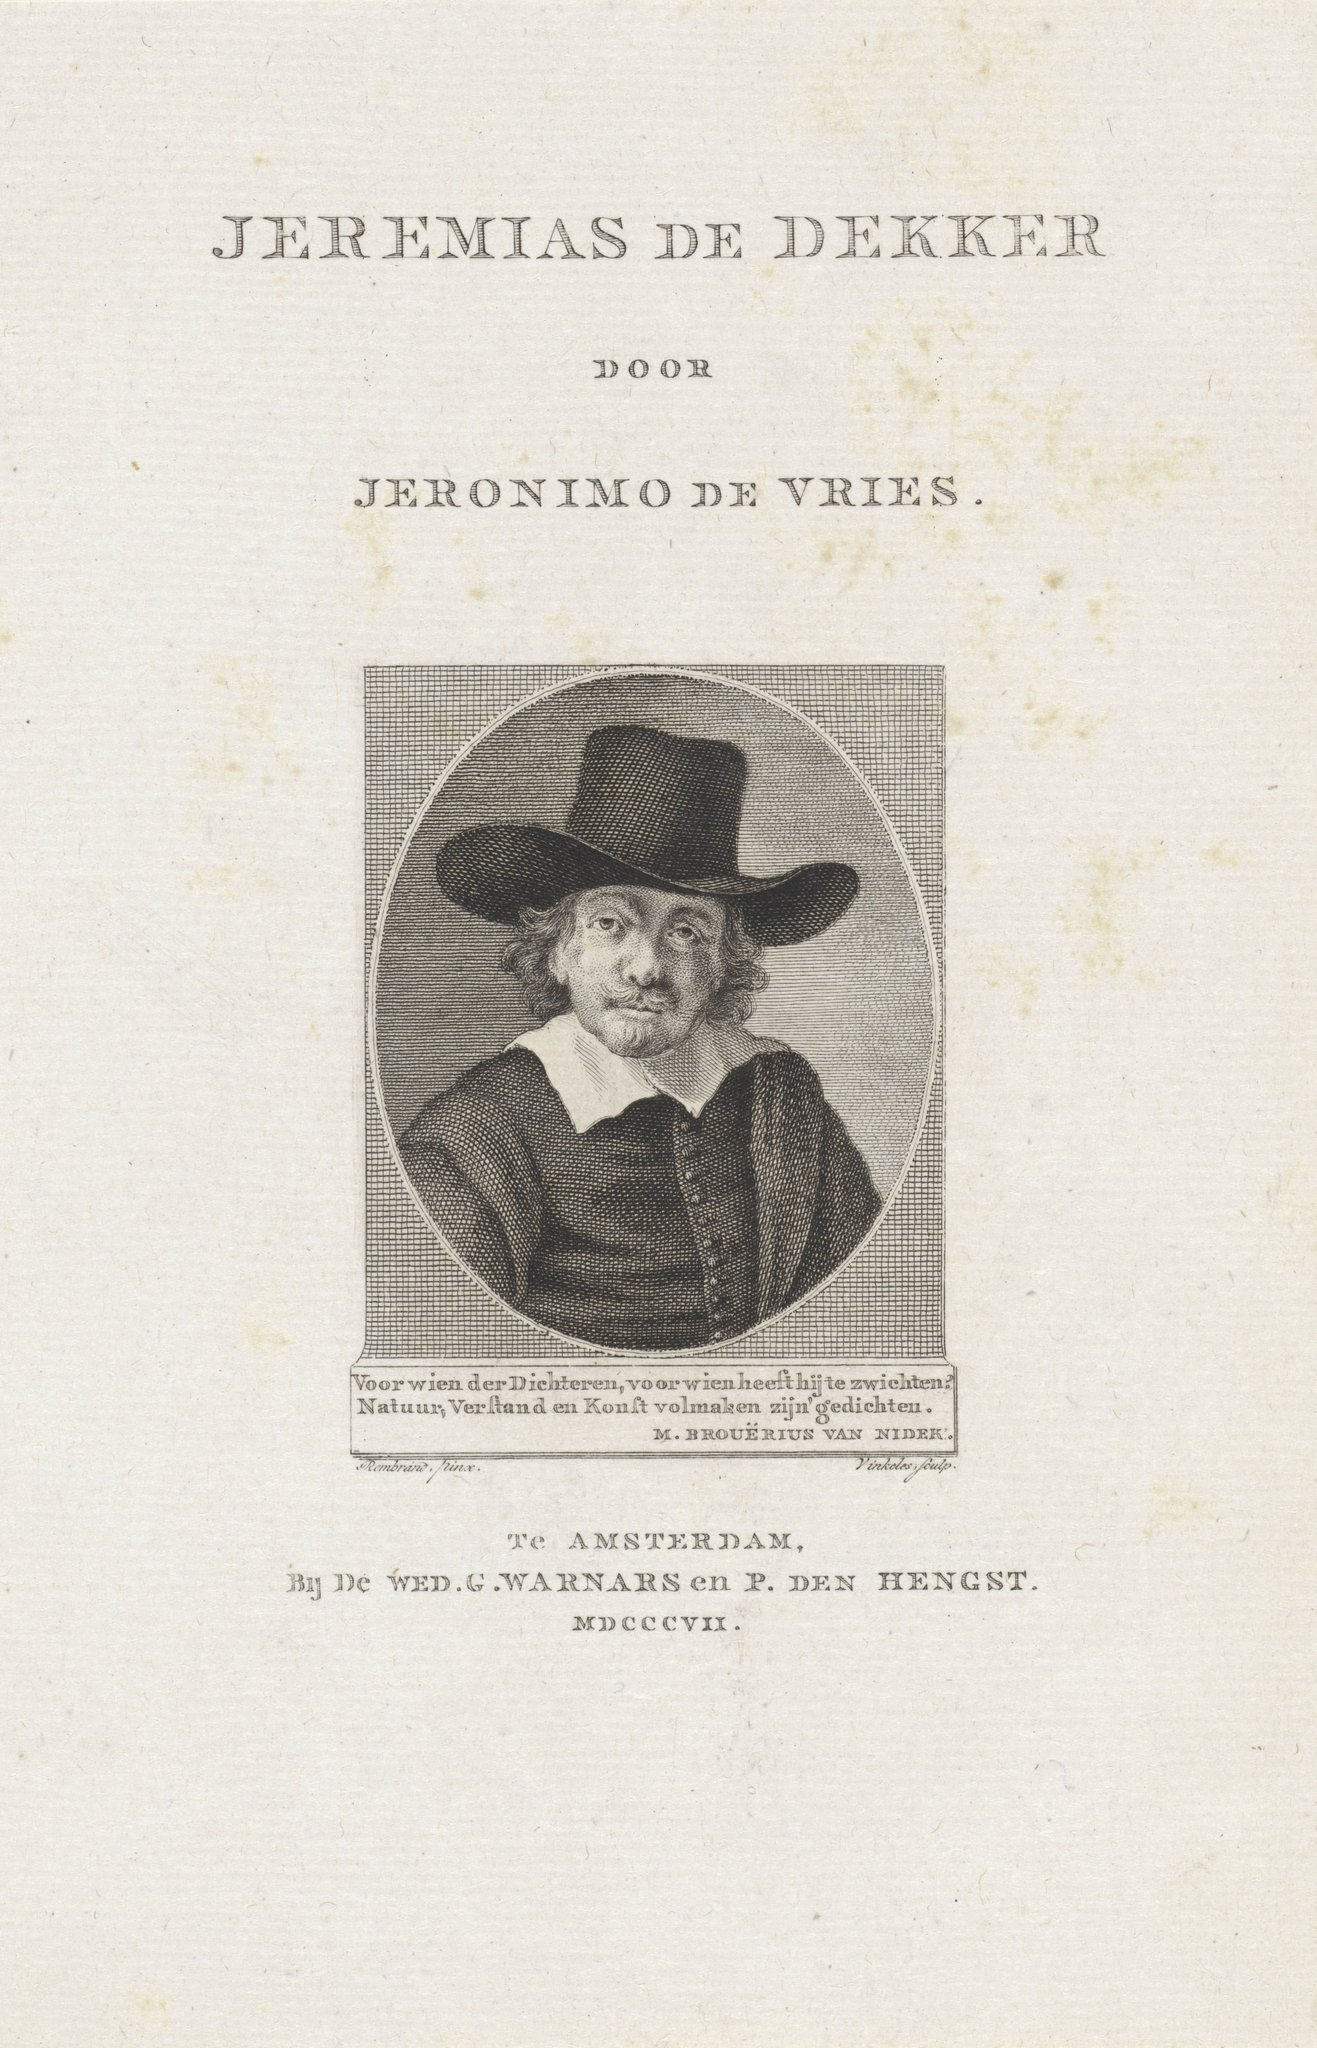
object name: titelblad, titelpagina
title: Portret van Jeremias de Decker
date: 1807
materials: paper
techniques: etching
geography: amsterdam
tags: dordrecht, amsterdam, jeremias de decker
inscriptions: collector's mark: Lugt 2228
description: Prent gebruikt als titelpagina voor: Vries, J. de. Jeremias de Dekker. Amsterdam: weduwe Gerrit Warnars en Petrus den Hengst, 1807.